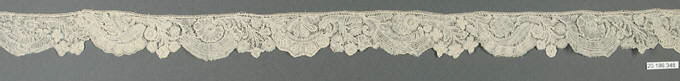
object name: edging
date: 1701-1733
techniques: lace